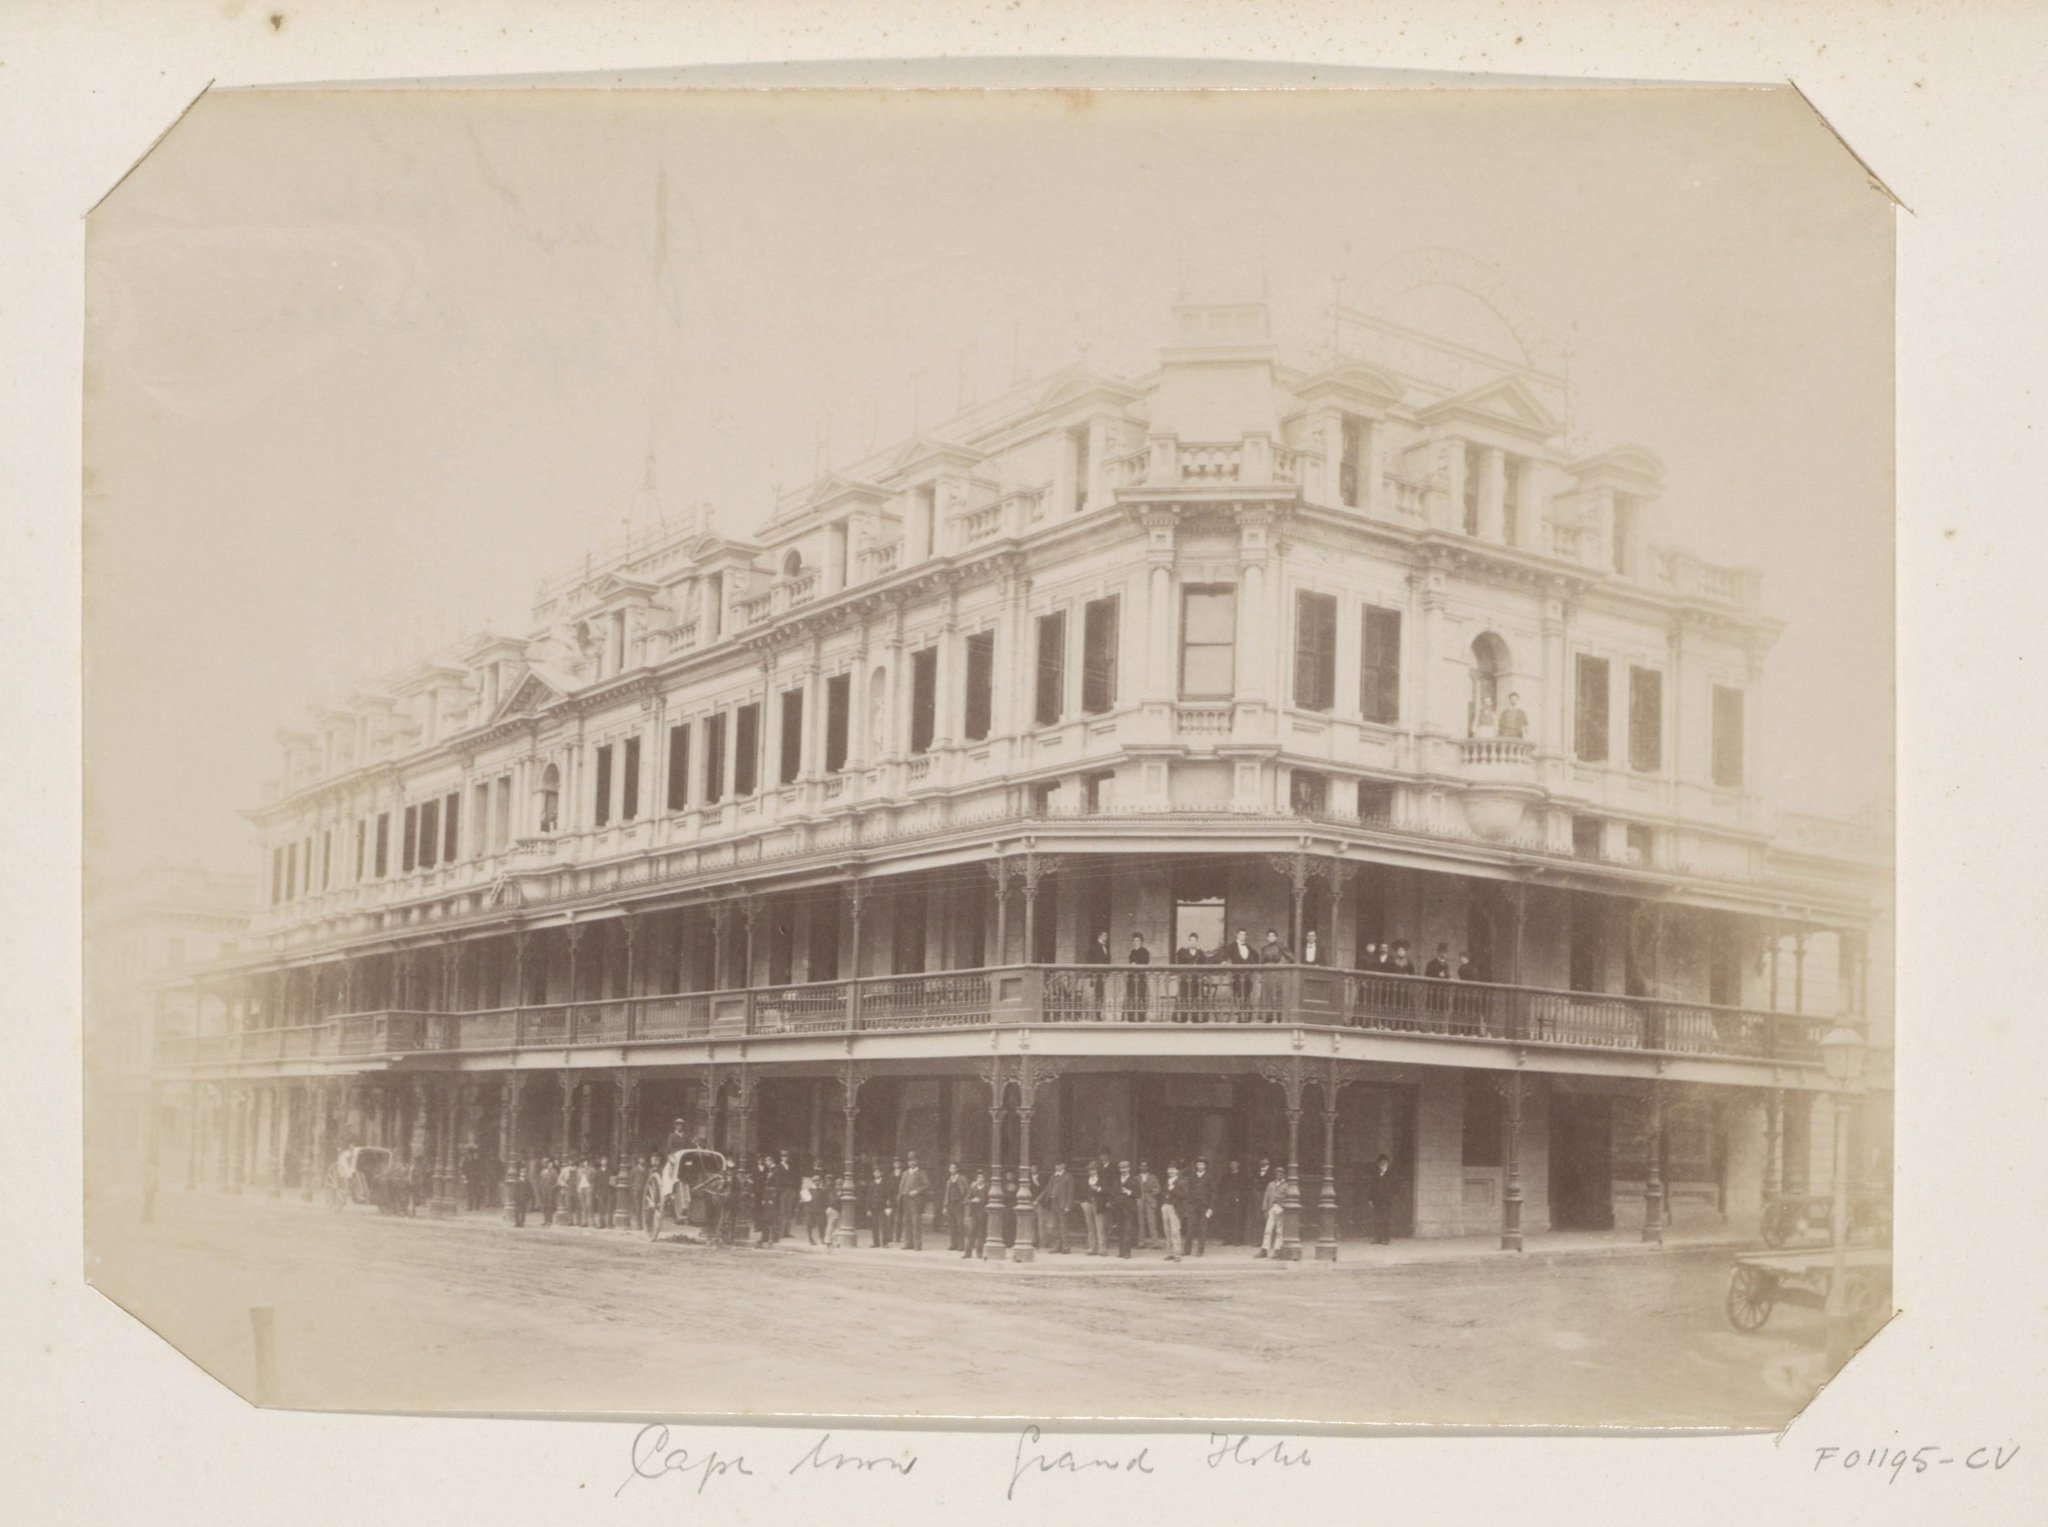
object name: photograph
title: Exterieur van het Grand Hotel in Kaapstad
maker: Anonymous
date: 1880-1910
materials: cardboard, paper, photographic support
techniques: albumen print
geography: cape town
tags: hotel, hostelry, inn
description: Onderdeel van Fotoalbum van een reis door de Verenigde Staten, Honolulu, Nederlands-Indië, Aden, Zanzibar en Zuidelijk Afrika.